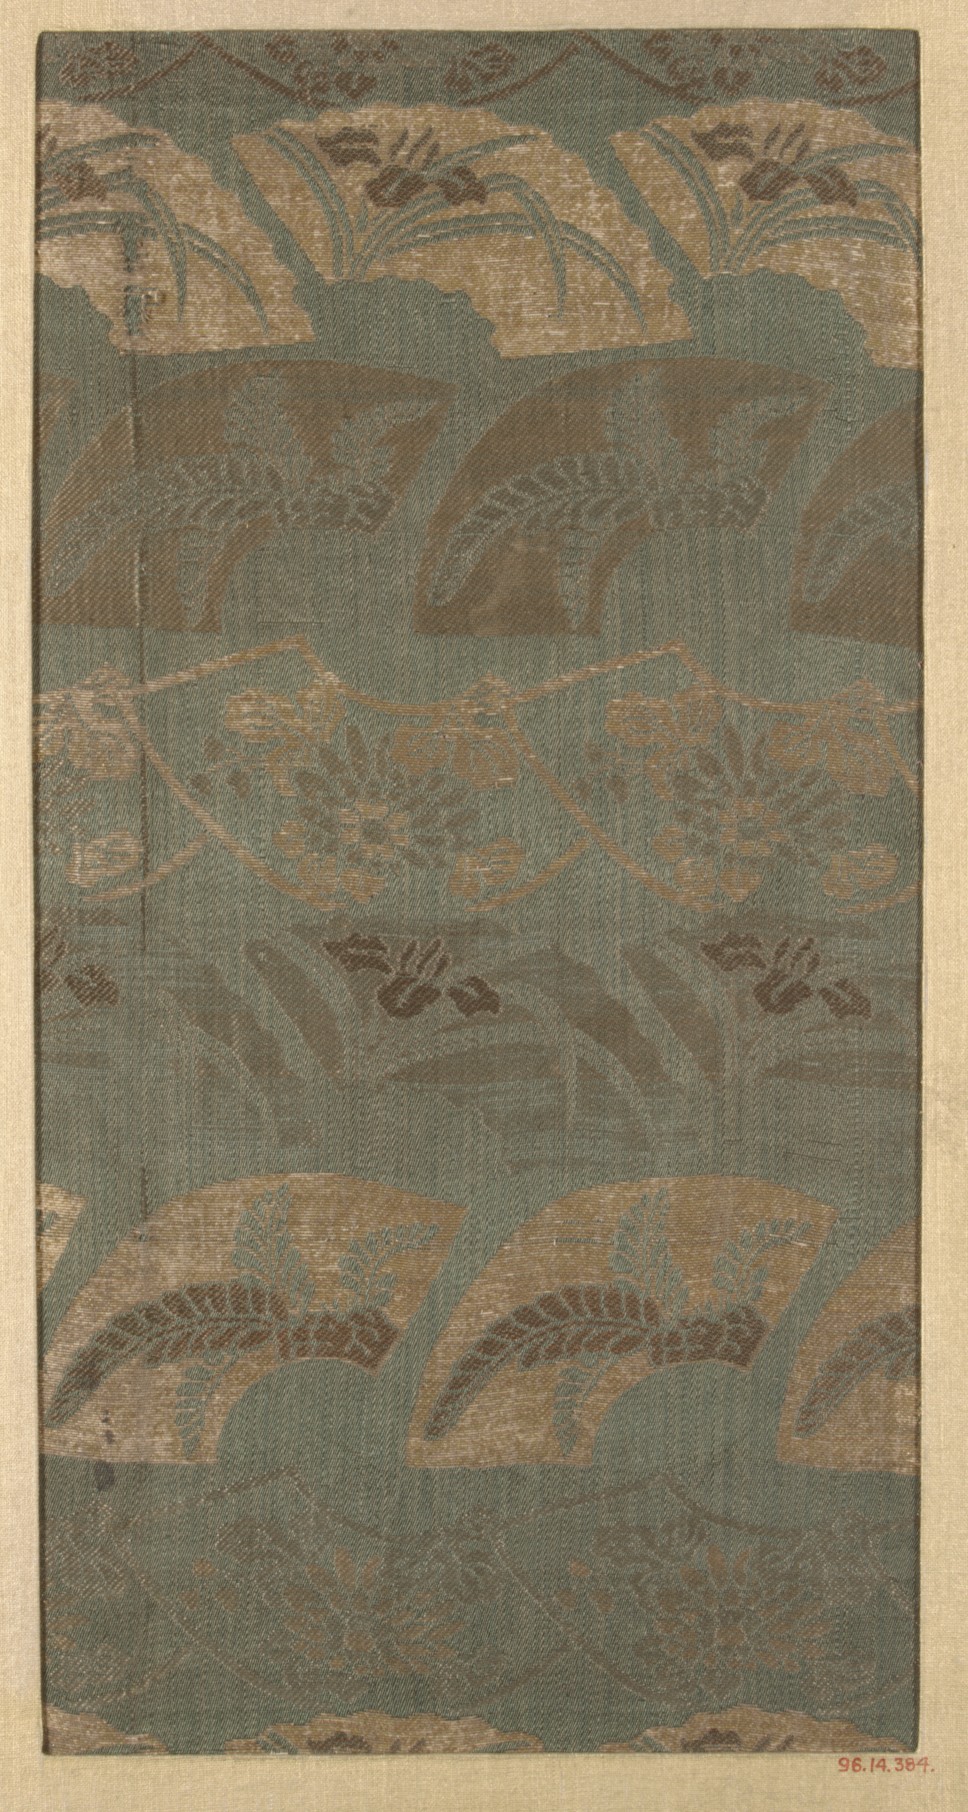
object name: piece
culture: japanese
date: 1701-1900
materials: silk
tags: fans,flowers